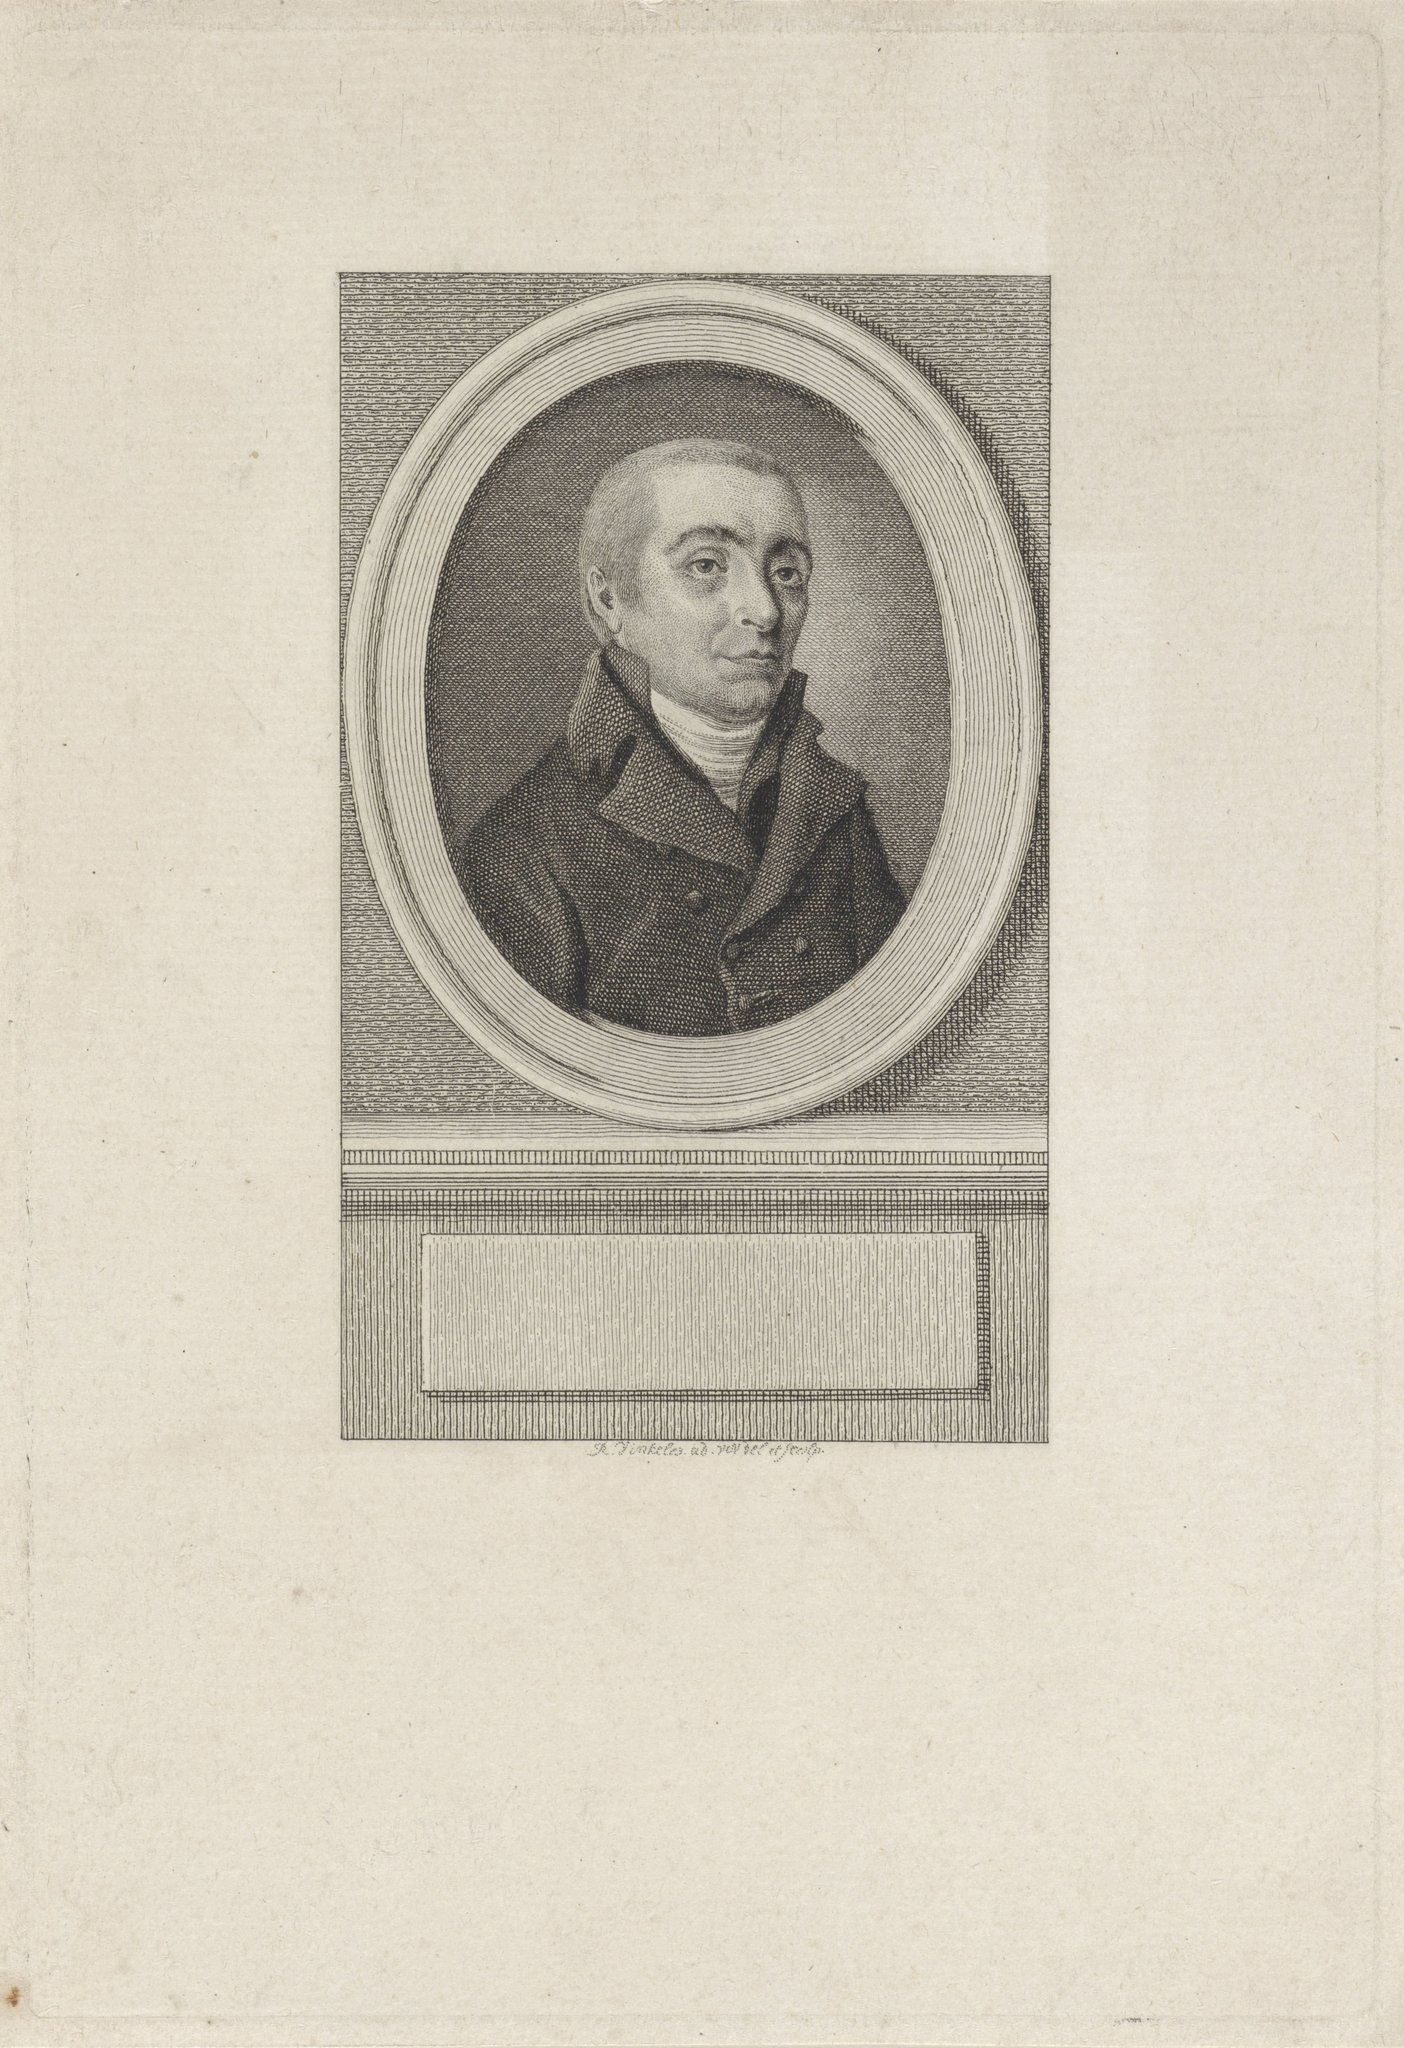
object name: print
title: Portret van Willem Anthonie Ockerse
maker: reinier vinkeles (i)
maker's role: draughtsman, print maker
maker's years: 1741-1816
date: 1786-1809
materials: paper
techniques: engraving, etching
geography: amsterdam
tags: politician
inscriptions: collector's mark: Lugt 2228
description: Latere staat prent gebruikt als boekillustratie in: Wagenaar, Jan. Vaderlandsche historie, (...) ten vervolge van Wagenaars Vaderlandsche historie. Dl. 1-43. Amsterdam: Johannes Allart, 1786-1809.